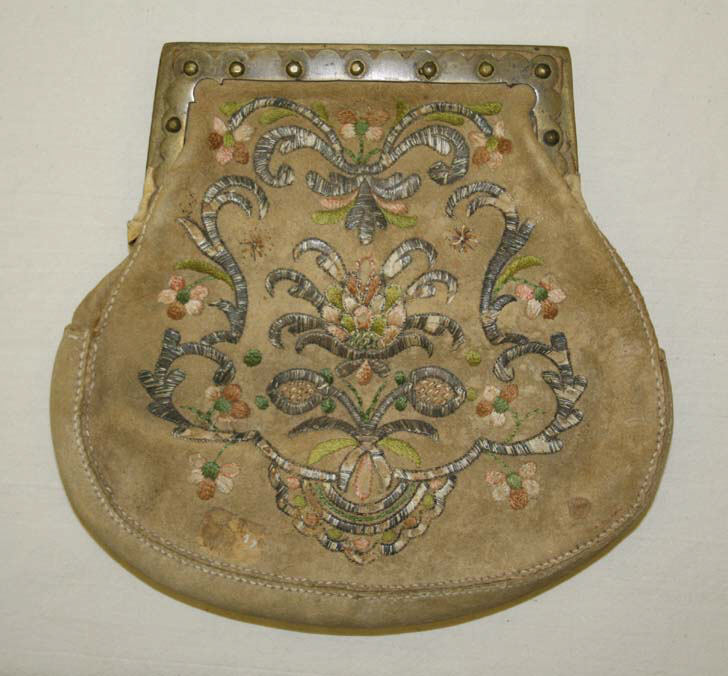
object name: bag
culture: italian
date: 1801-1900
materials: leather